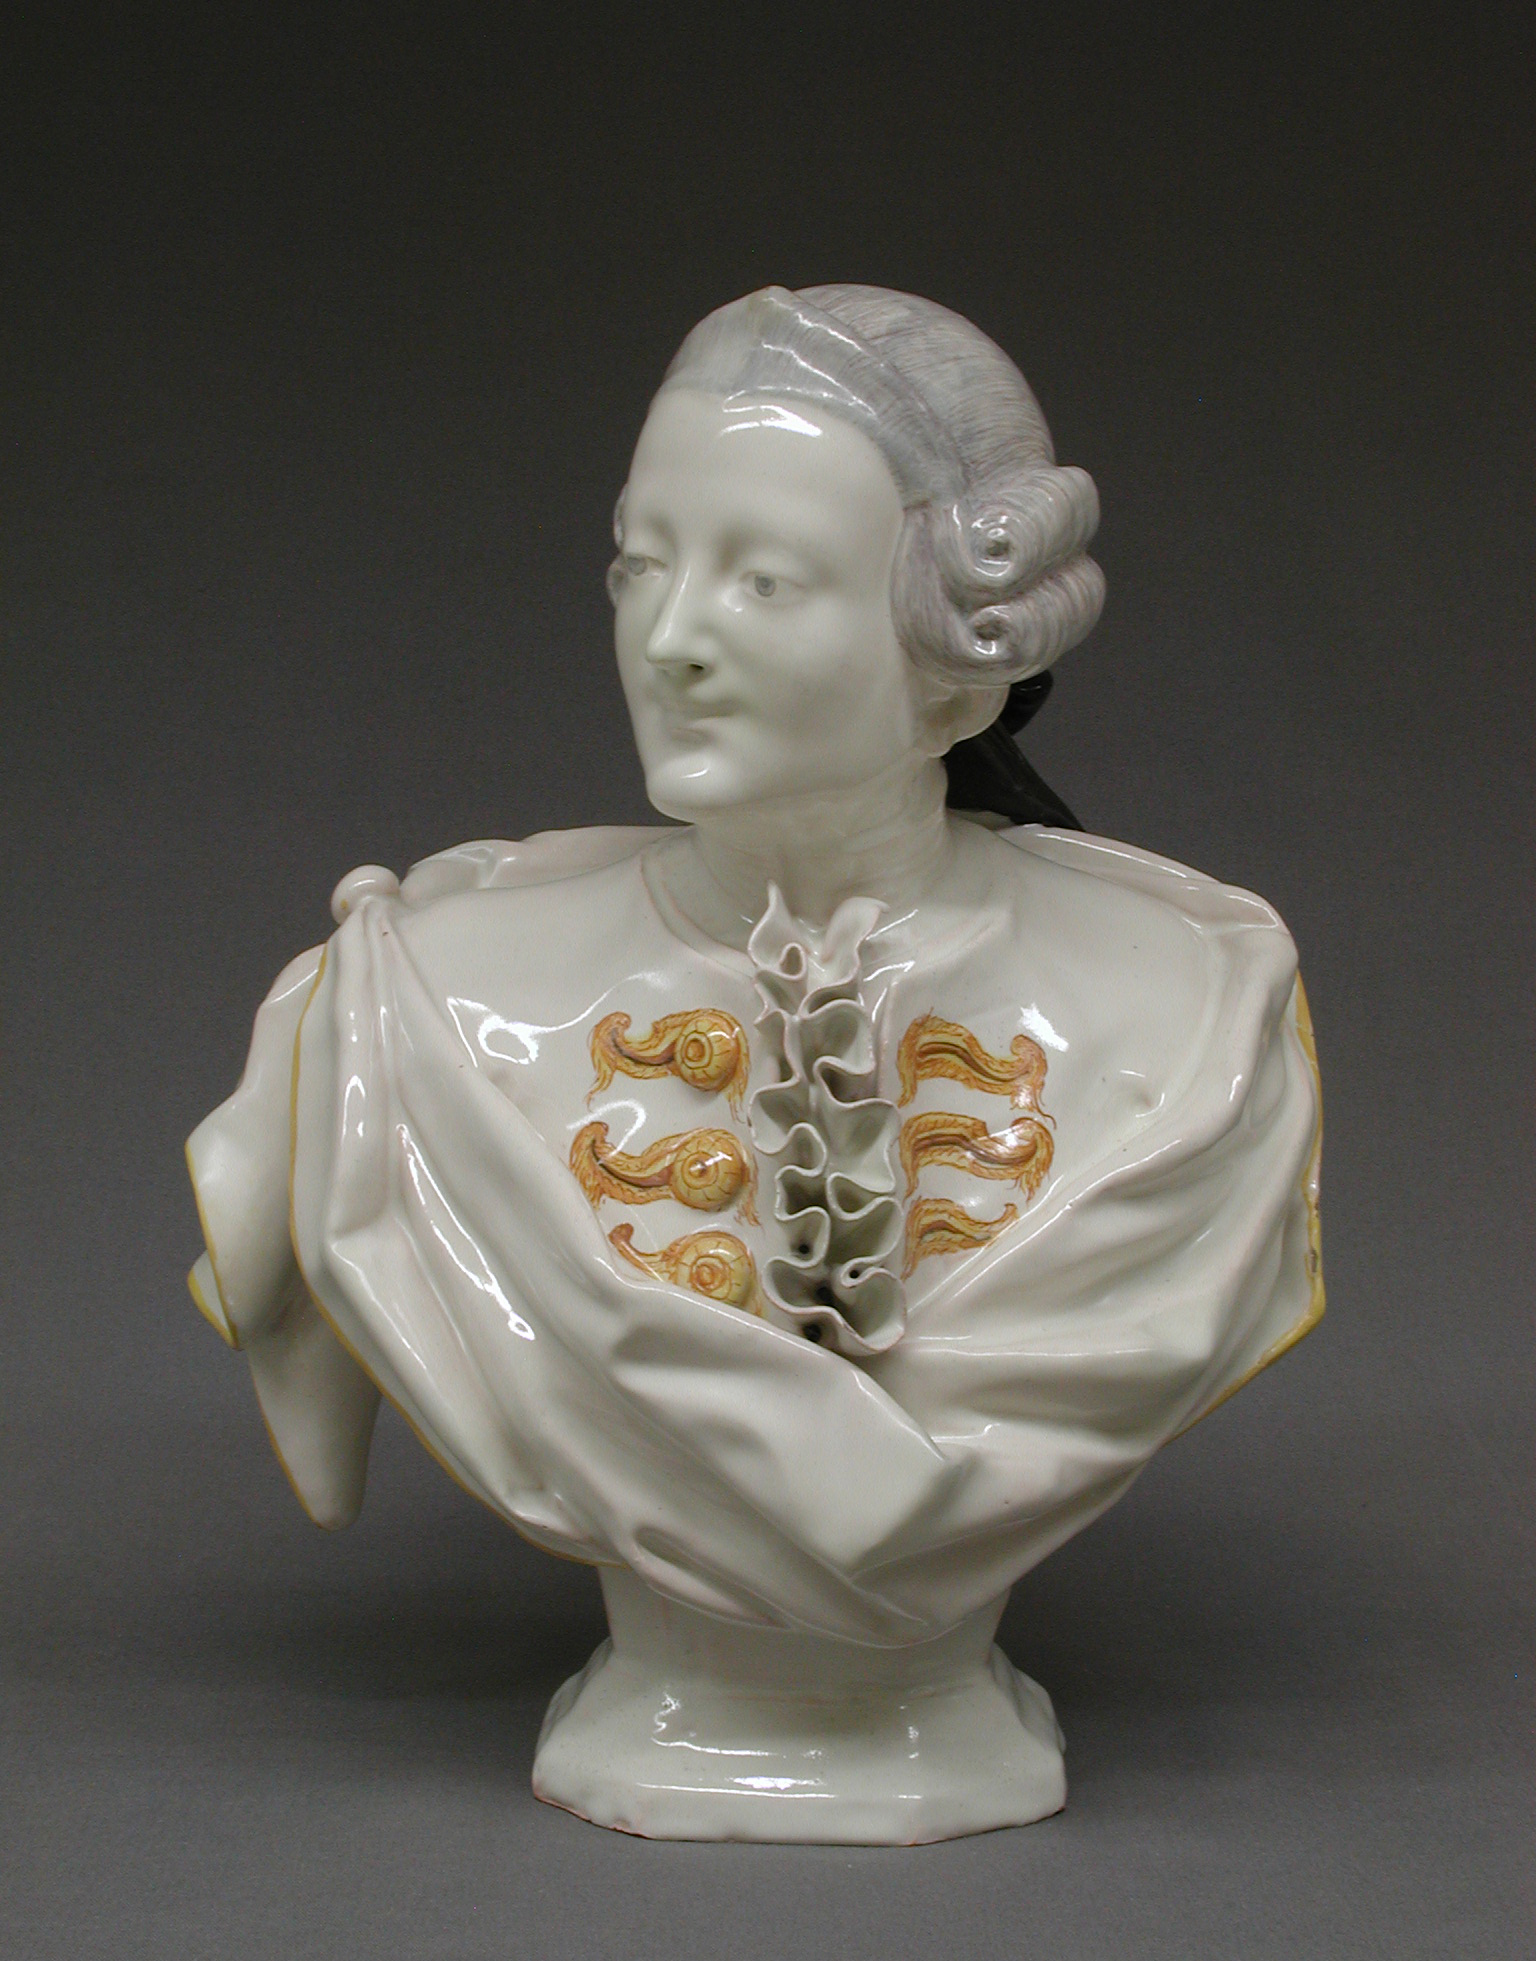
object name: bust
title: Bust of a Spanish nobleman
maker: alcora manufactory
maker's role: factory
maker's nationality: spanish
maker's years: 1727-1895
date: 1750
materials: earthenware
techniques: glazing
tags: men,portraits